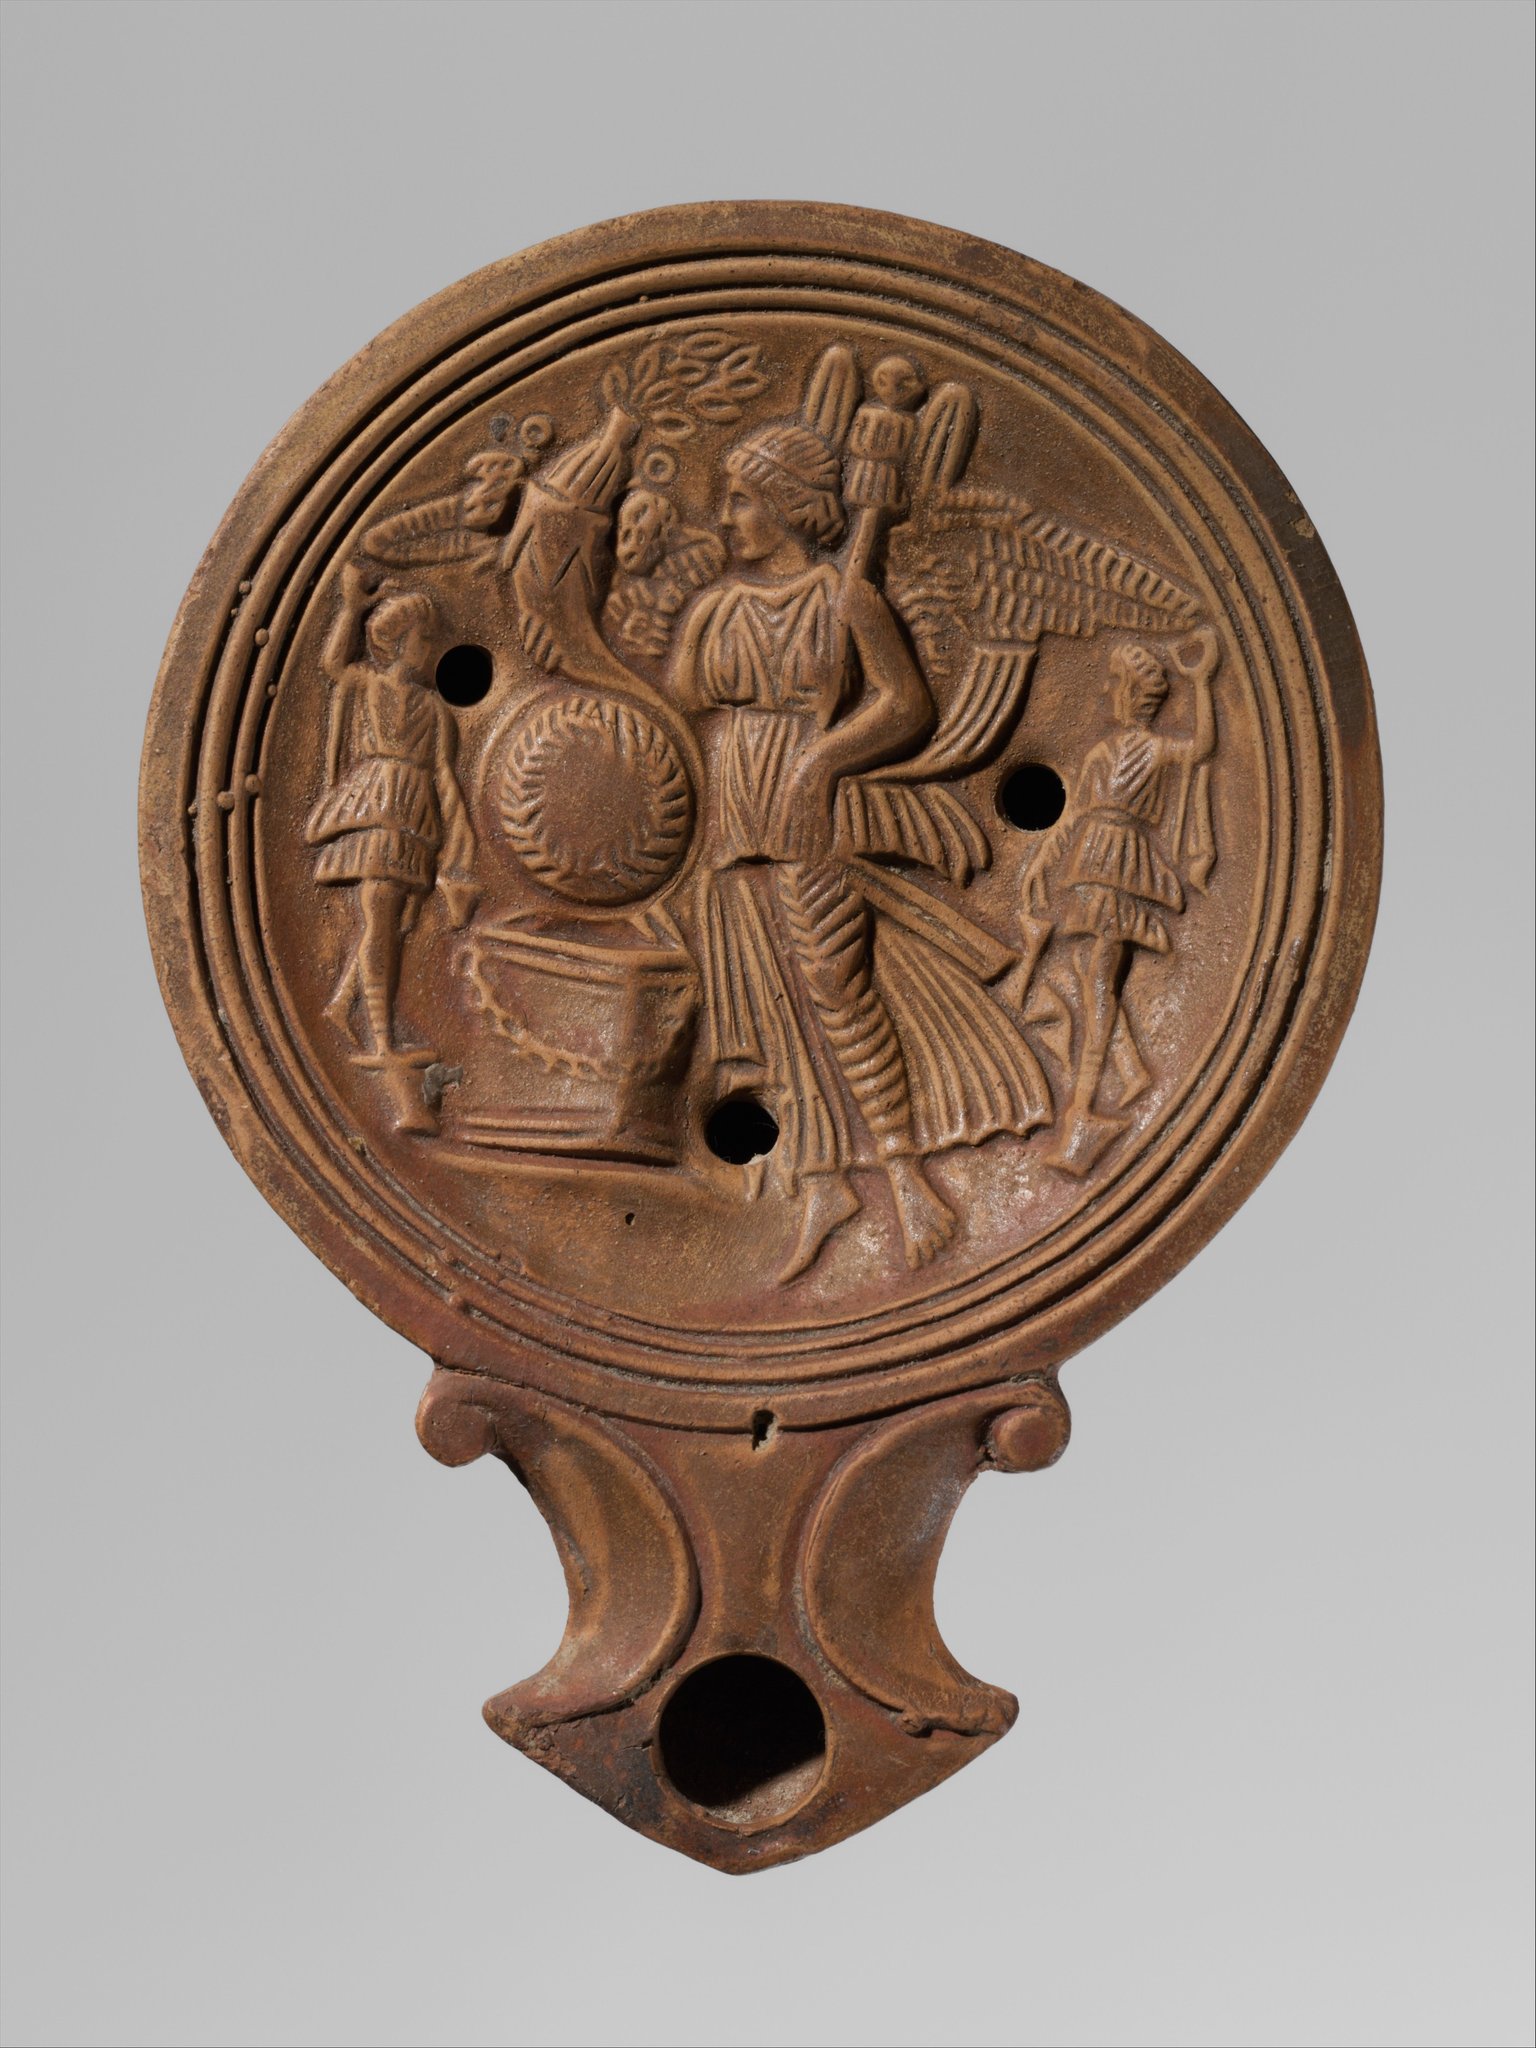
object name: lamp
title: Terracotta oil lamp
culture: roman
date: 1-100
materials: terracotta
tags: victory